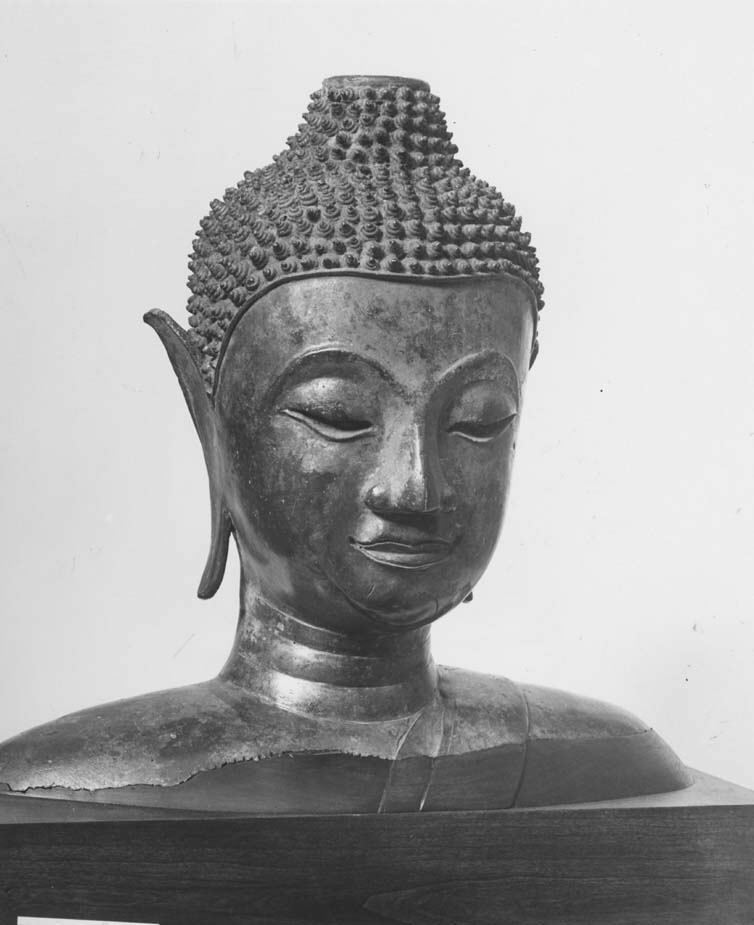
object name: bust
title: Buddha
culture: thai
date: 1401-1500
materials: bronze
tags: buddhism,buddha